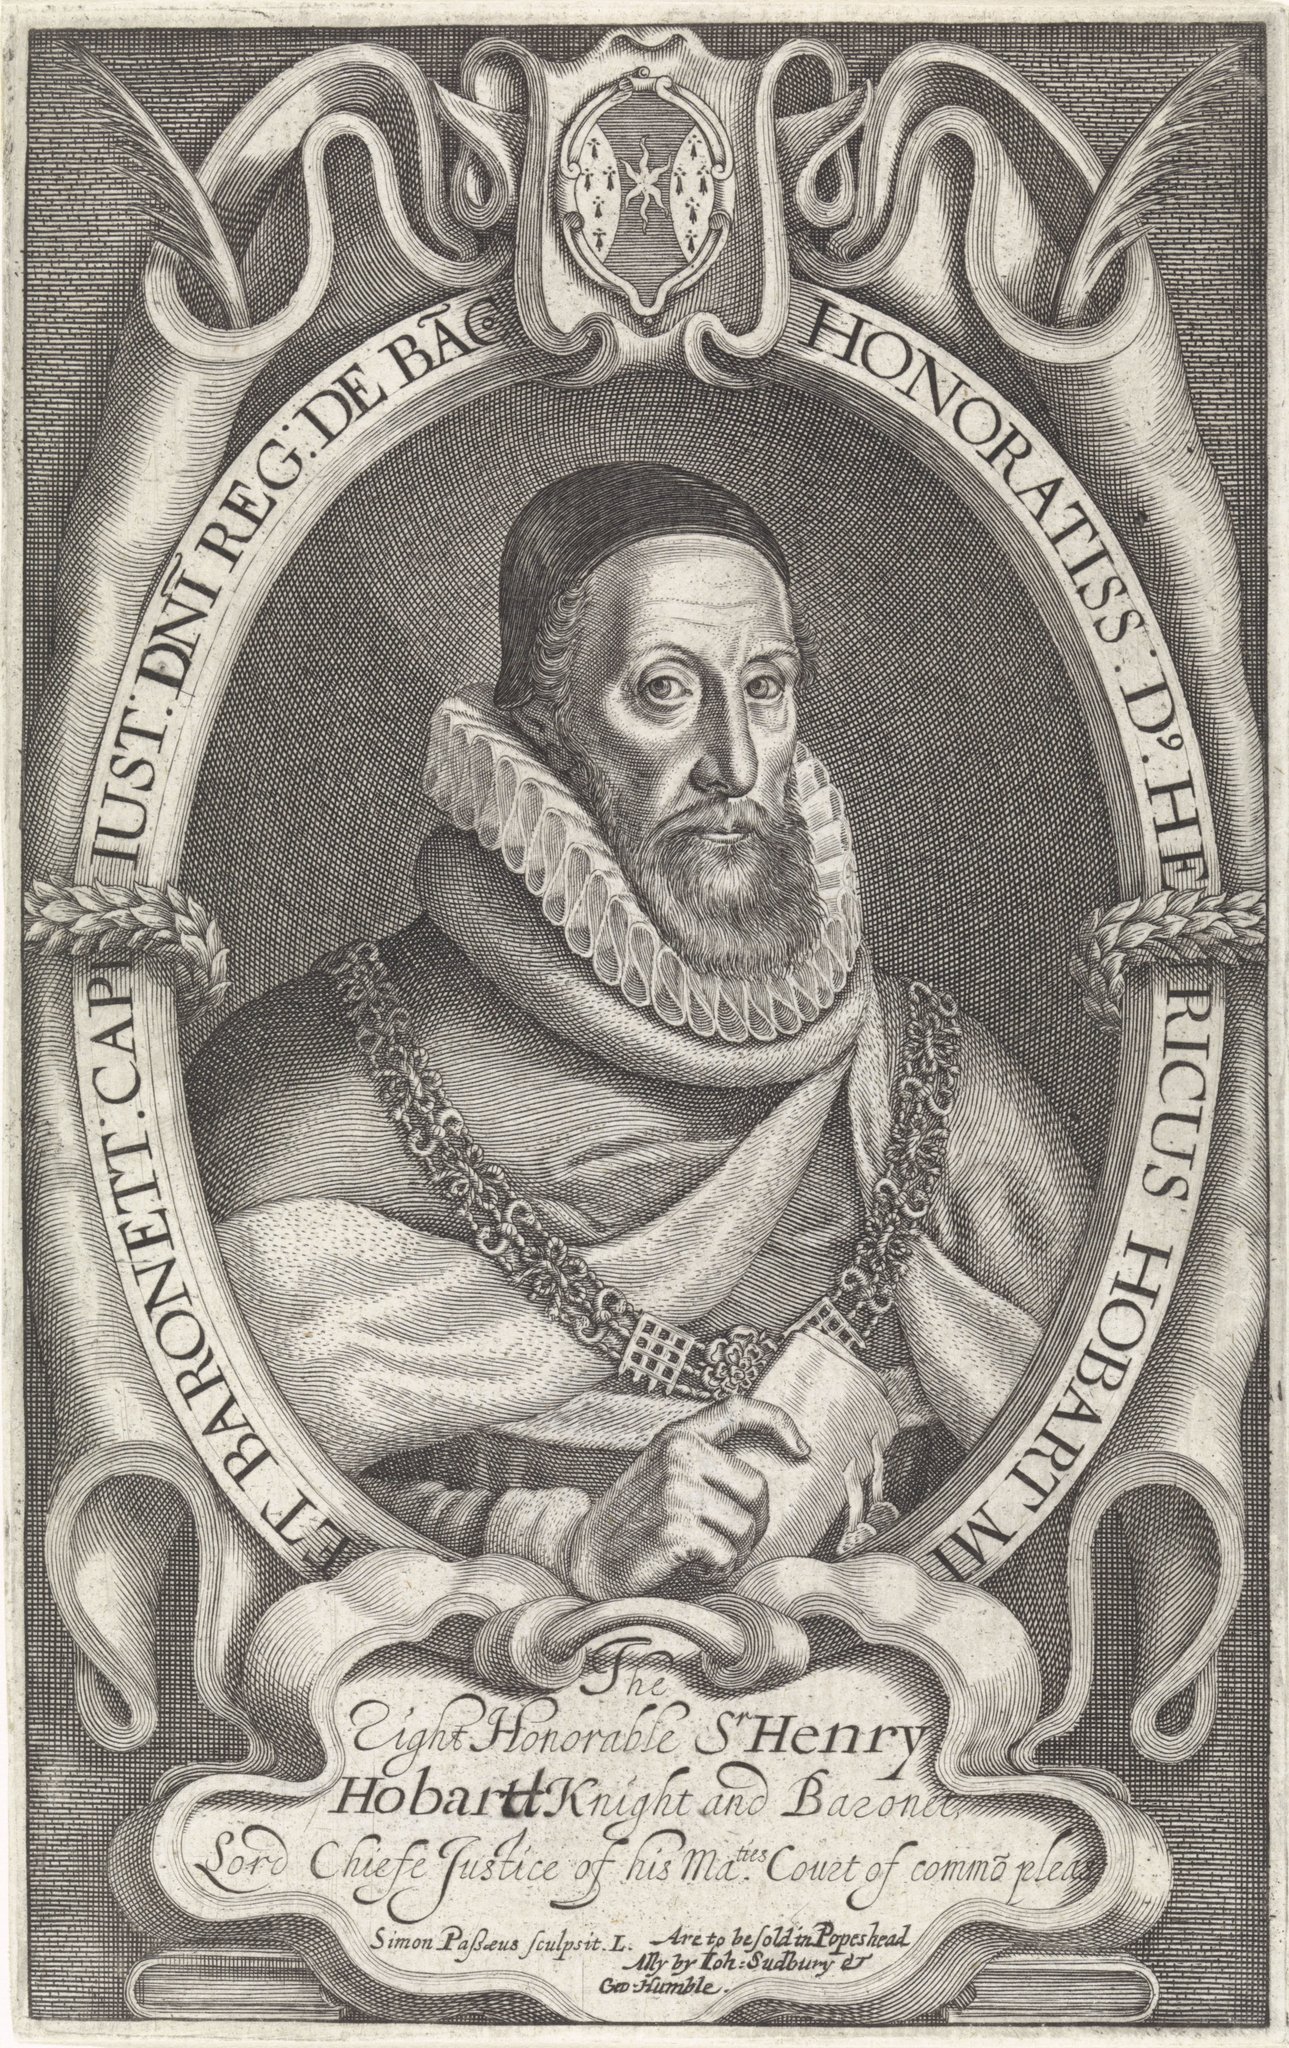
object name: print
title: Portret van Henry Hobart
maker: simon van de passe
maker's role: print maker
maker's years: 1595-1647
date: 1615-1622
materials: paper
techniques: engraving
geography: london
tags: politician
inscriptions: collector's mark: Lugt 2228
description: Portret van de Engelse rechter en politicus Sir Henry Hobart. In het randschrift van de omlijsting de naam en functie van de geportretteerde in het Latijn. Bovenaan de omlijsting het wapenschild van de geportretteerde. In de cartouche onder de omlijsting een vierregelig onderschrift met de naam en functie van de geportretteerde in het Engels.